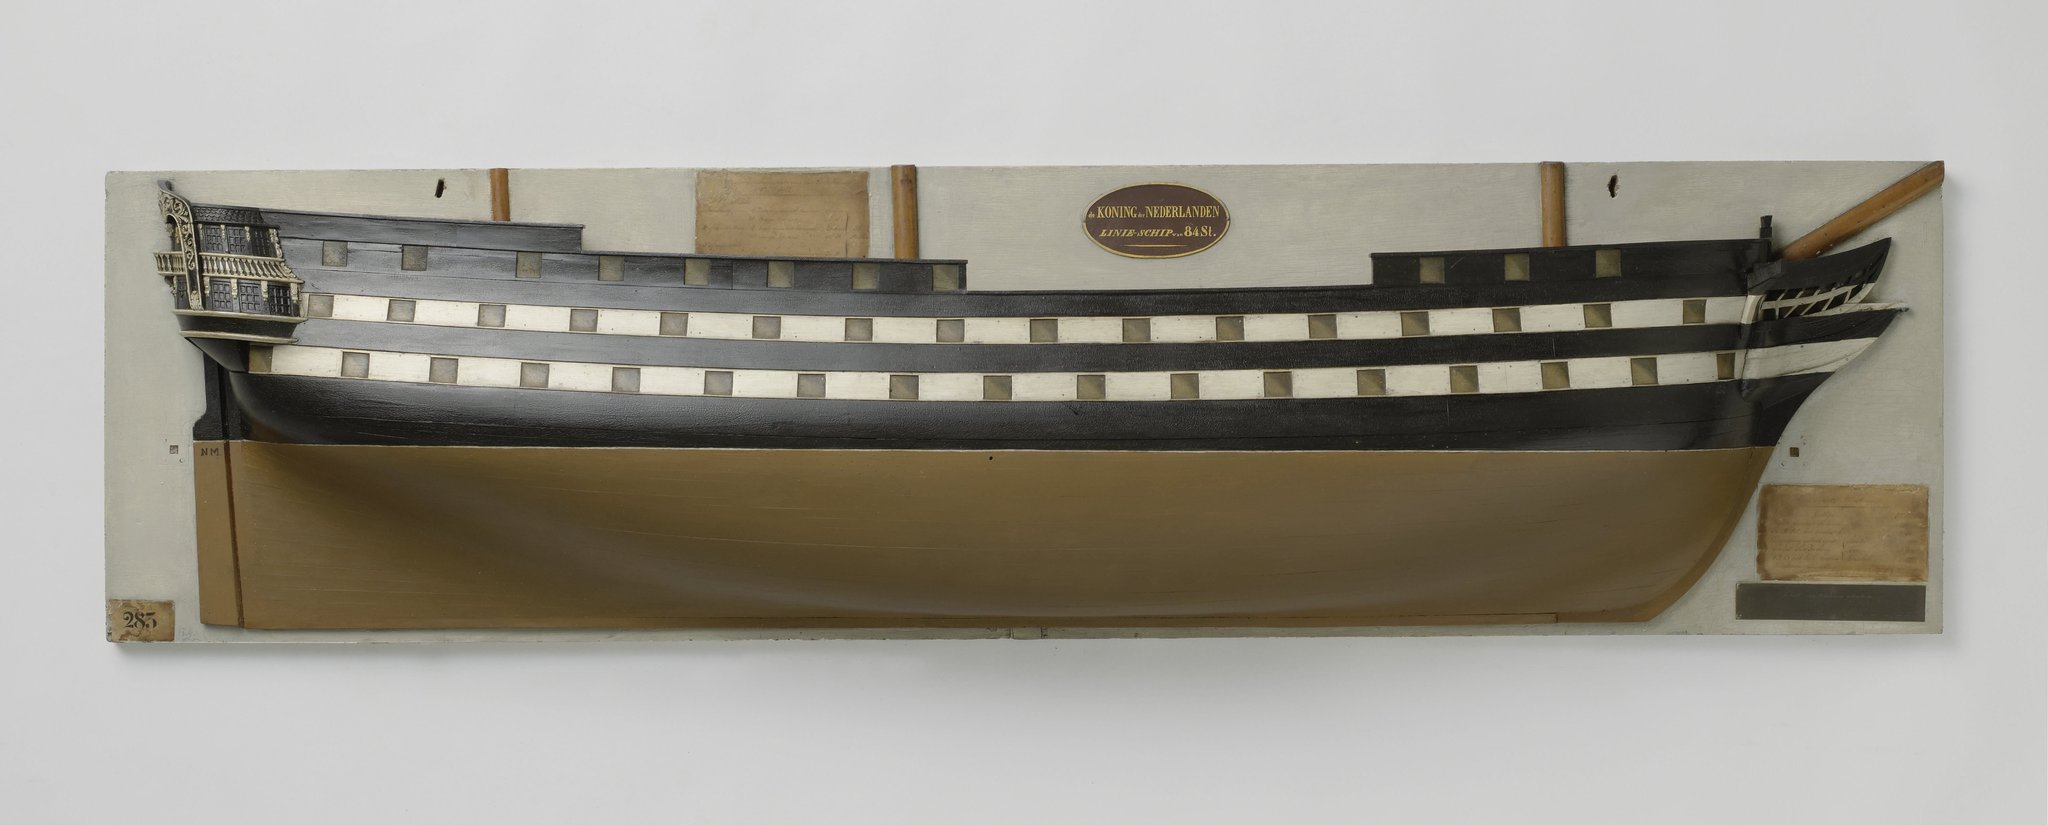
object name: half model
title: Half Model of an 84-Gun Ship of the Line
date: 1836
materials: brass, wood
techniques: polychromy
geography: flushing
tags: koning der nederlanden (schip), neptunus (schip)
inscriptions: inscription, top left, on a piece of paper, in ink: ‘Volgens de resolutie van den 27 February / 1843 Nº 69 D. / [followed by armament]’, inscription, bottom right, on a piece of paper, in ink: ‘Voornaamste Afmetingen / [followed by measurements]’, inscription, on the rudder: ‘NM’ former property mark, scale, bottom right: brass scale in inches, inscription, top centre, on an oval brown metal label: ‘de KONING der NEDERLANDEN / LINIE-SCHIP van 84 St.’, label, bottom left: ‘283’ former inventory label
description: Geheel beplankt gepolychromeerd mallenmodel of blokmodel (stuurboord) van een driemaster. Acht en veertig geschutpoorten verdeeld over drie dekken. Rond achterschip met wulf en hek van twee verdiepingen, uitvoerig versierd, met westergang aan de bovenste verdieping, gesteund door versierde knieën. Op de verschansing boven het hek gesneden lofwerk met het monogram van koning Willem I; tegen de westergang het (halve) Rijkswapen. Recht roer met vierkante roerkoning. De zeeg loopt iets op aan beide uiteinden, twee berghouten en één reehout. Het model is van alle rusten met jufferblokken voorzien. Het onderwaterschip is rond, maar achter scherp weggesneden. Schaal 1:50 (schaal op model).